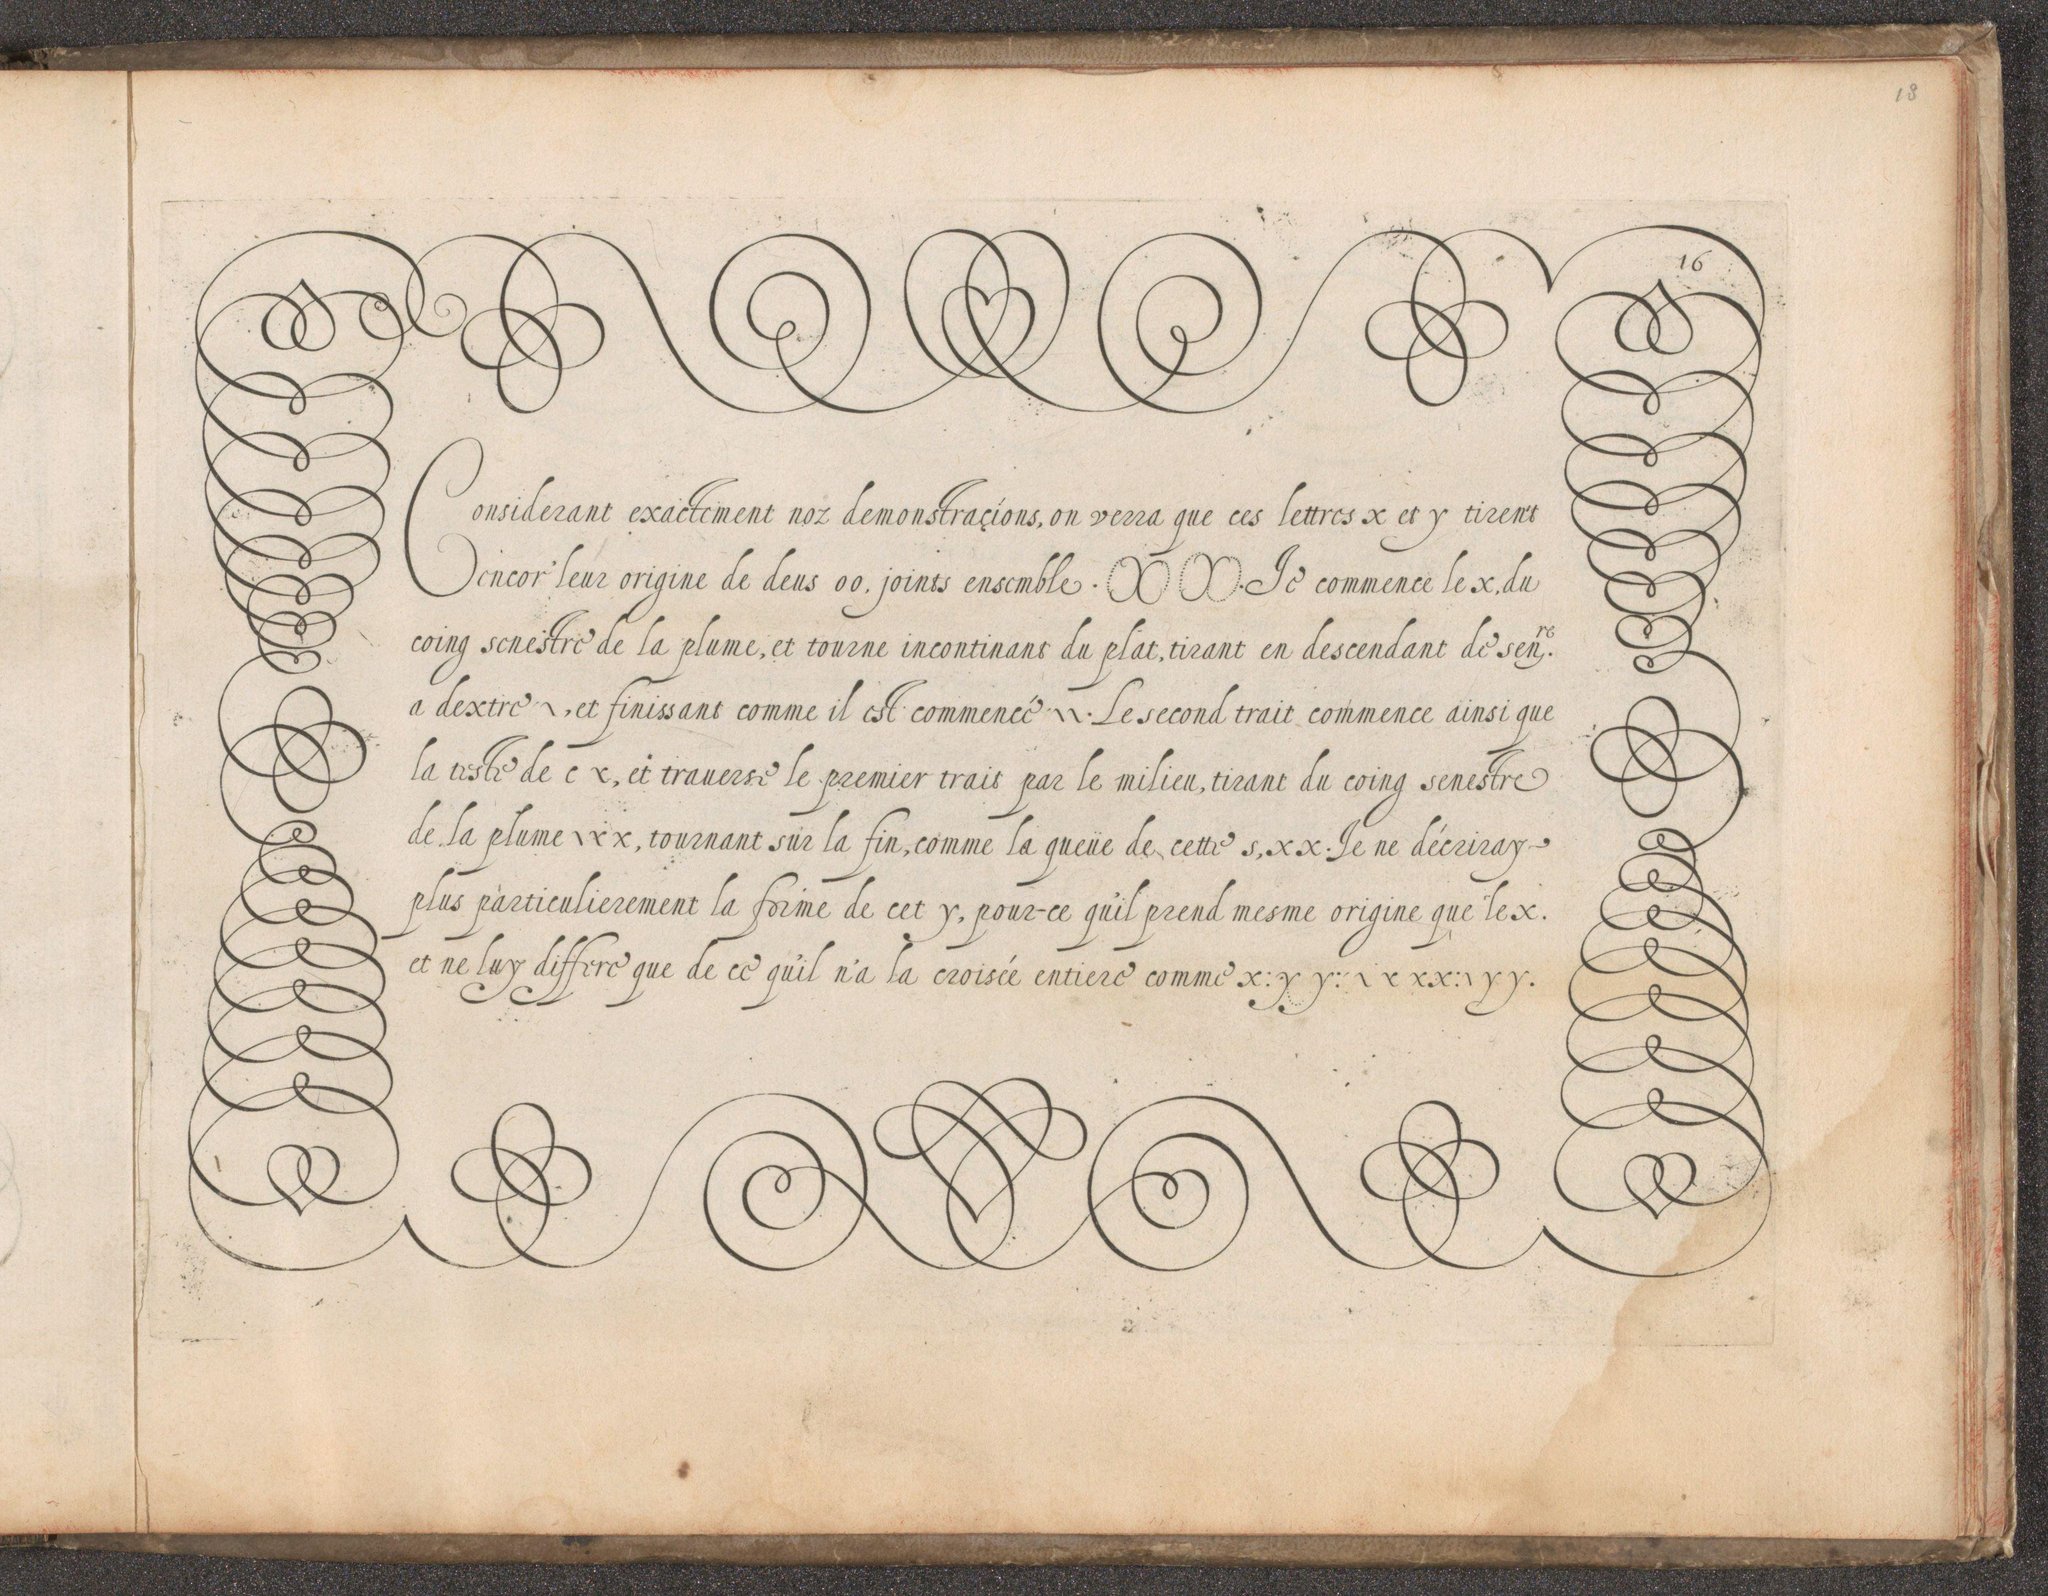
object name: album leaf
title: Les Oeuvres [(...)] Ou l'on comprendre facilement la manier de bien et proprement escrire toute sorte de lettre Italienne selon l'usage de ce siècle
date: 1608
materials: paper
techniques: engraving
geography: avignon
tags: calligraphy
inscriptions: signature and date: ‘Op titelblad: Judoco Hondio celatore. Amstelodami apud Joannem Janssonium. 1614’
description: Schrijfvoorbeeld in een humanistische hand met acht regels tekst in het Frans. De tekst is omlijst door krulwerk. De prent maakt deel uit van een album.